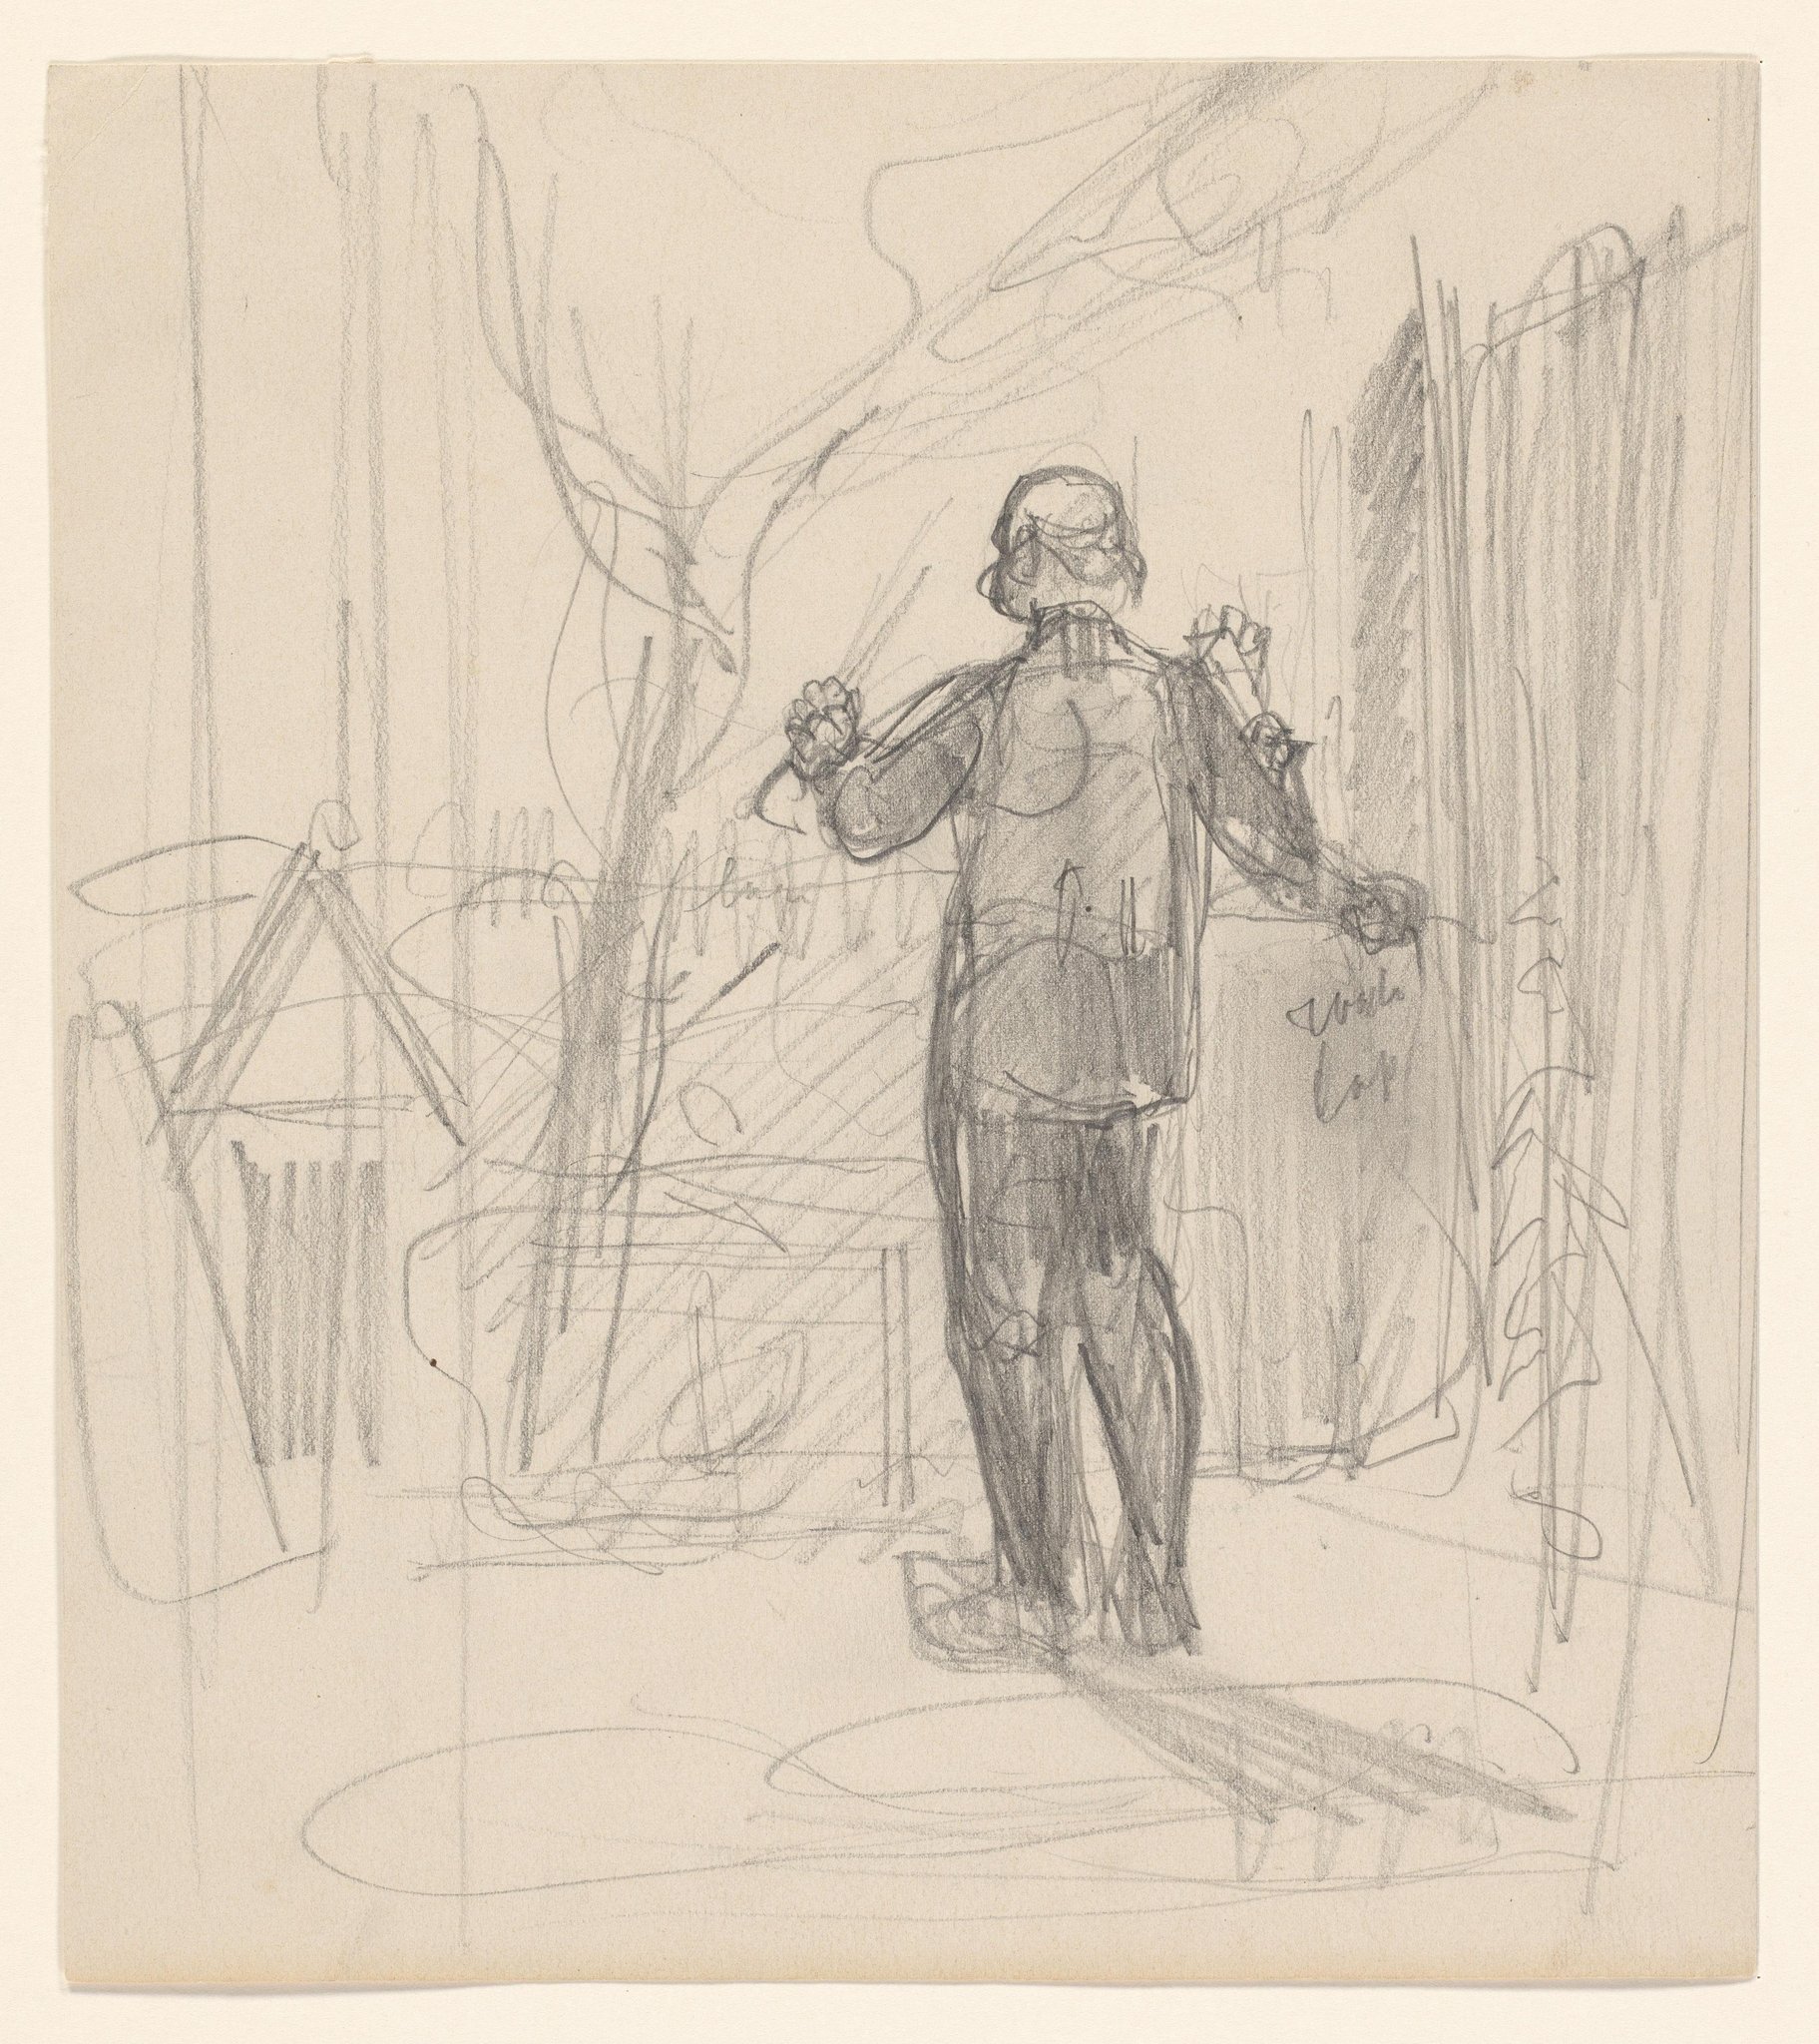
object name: drawing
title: Staande man op de rug gezien in een bebouwde omgeving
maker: august allebé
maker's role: draughtsman, print maker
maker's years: 1838-1927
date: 1848-1927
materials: paper, pencil